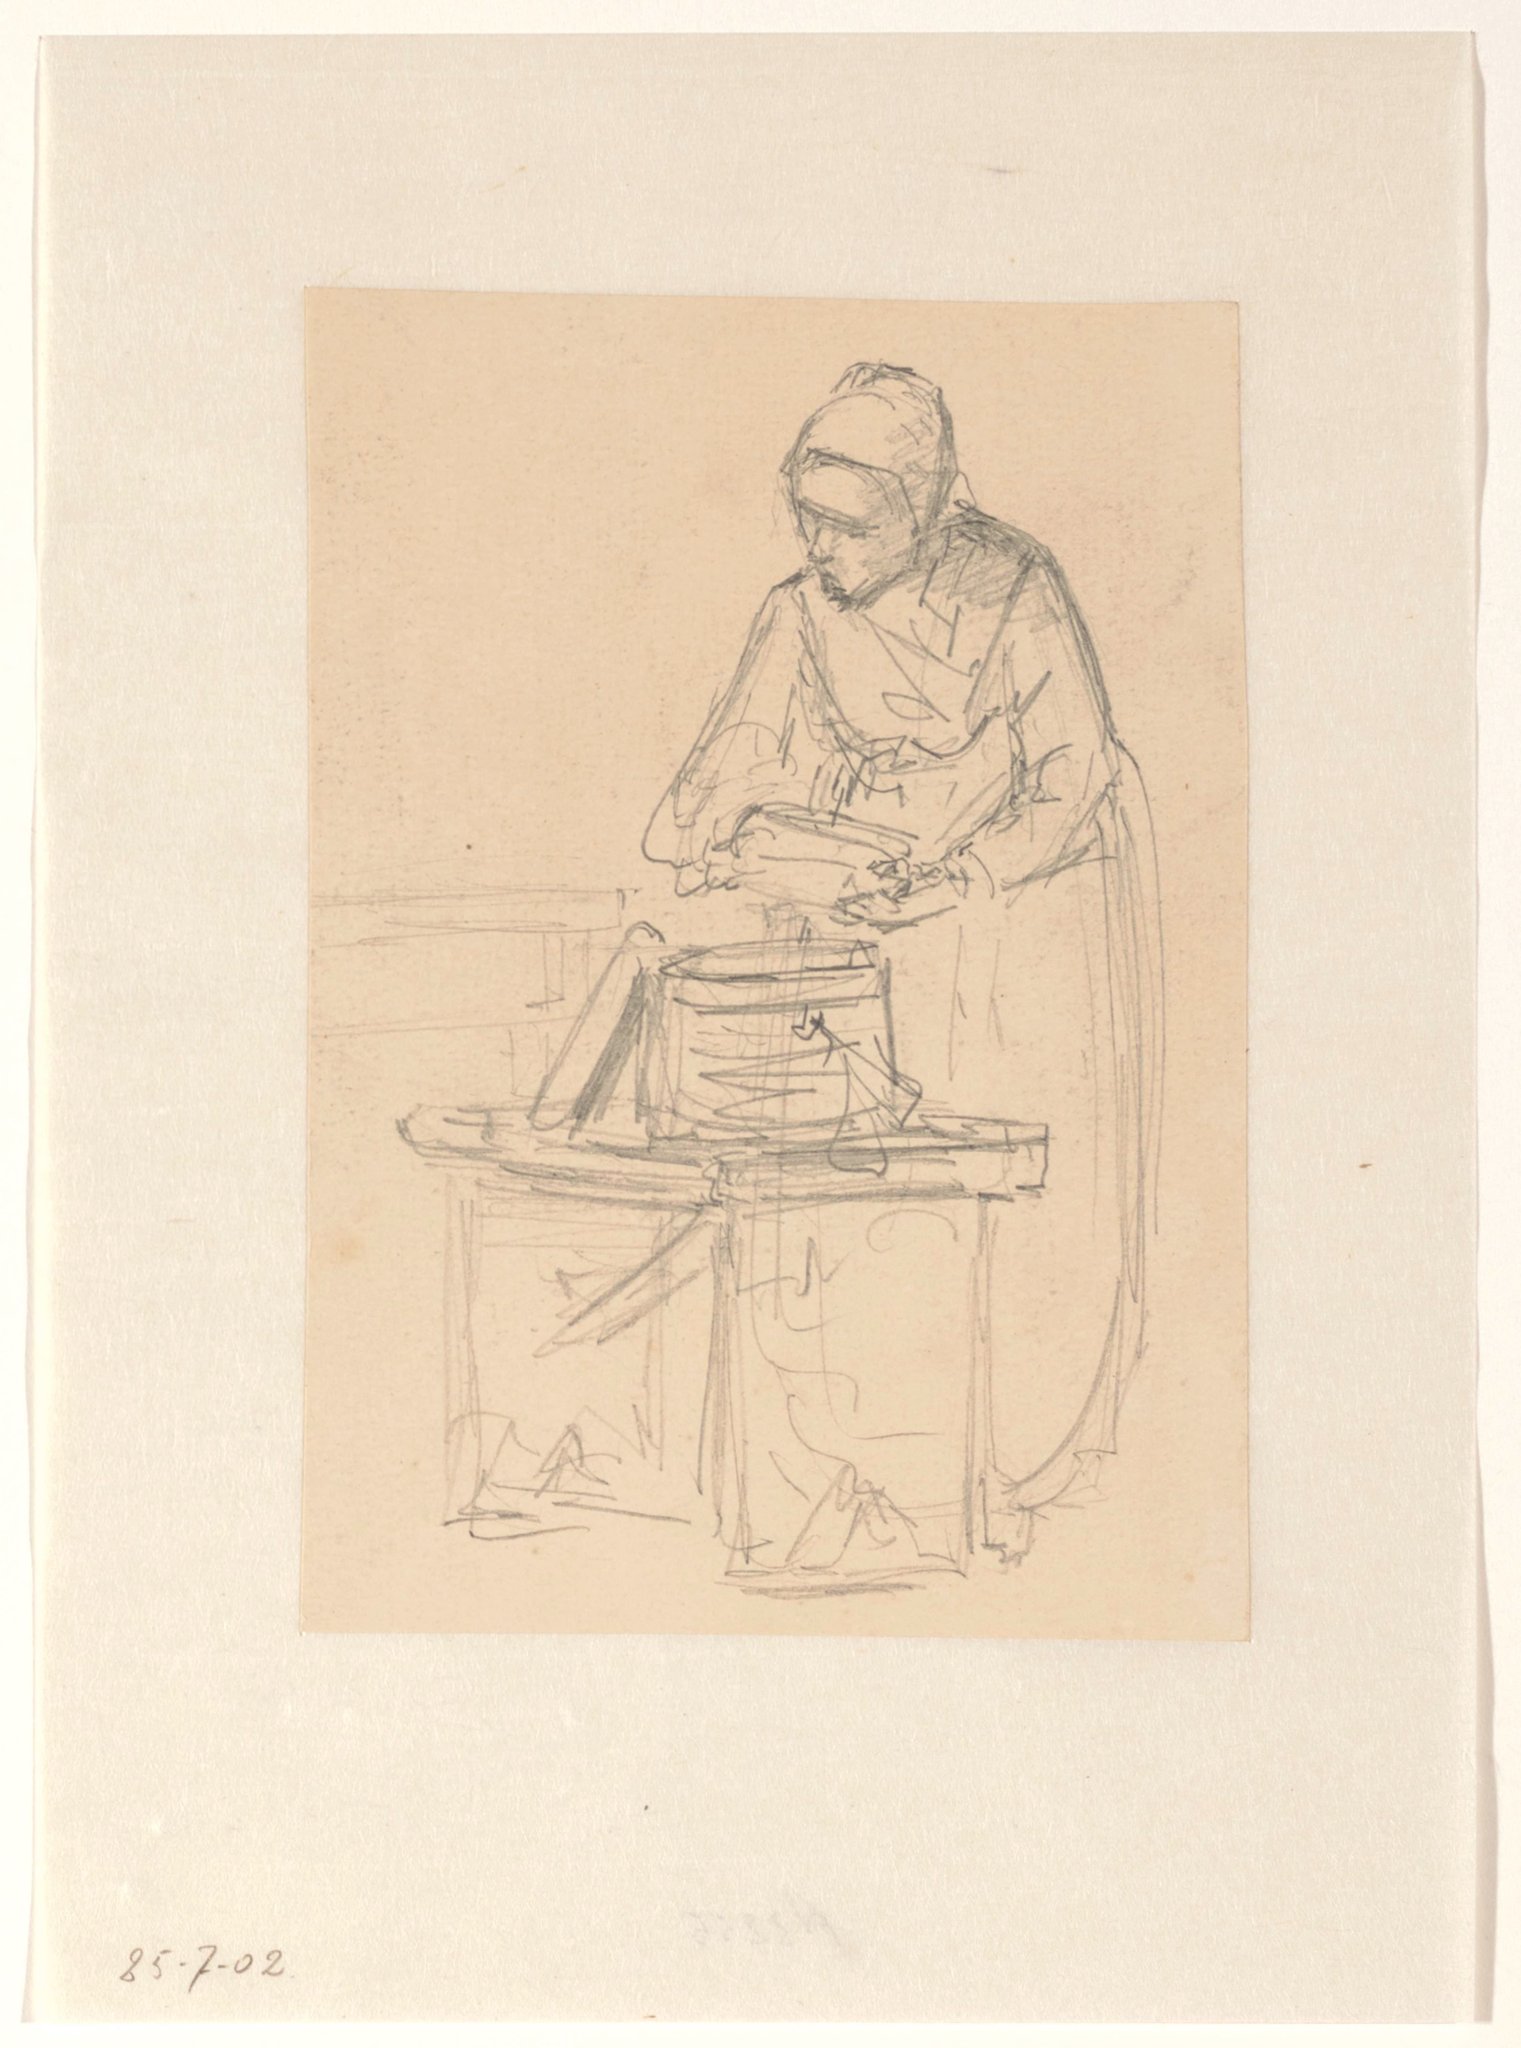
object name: drawing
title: Vrouw met vaatwerk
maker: hendrik valkenburg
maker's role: draughtsman, painter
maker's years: 1826-1896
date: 1836-1896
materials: paper, pencil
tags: adult woman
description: Een vrouw schudt iets uit een bus die ze met beide handen vasthoudt. Verso: schets.